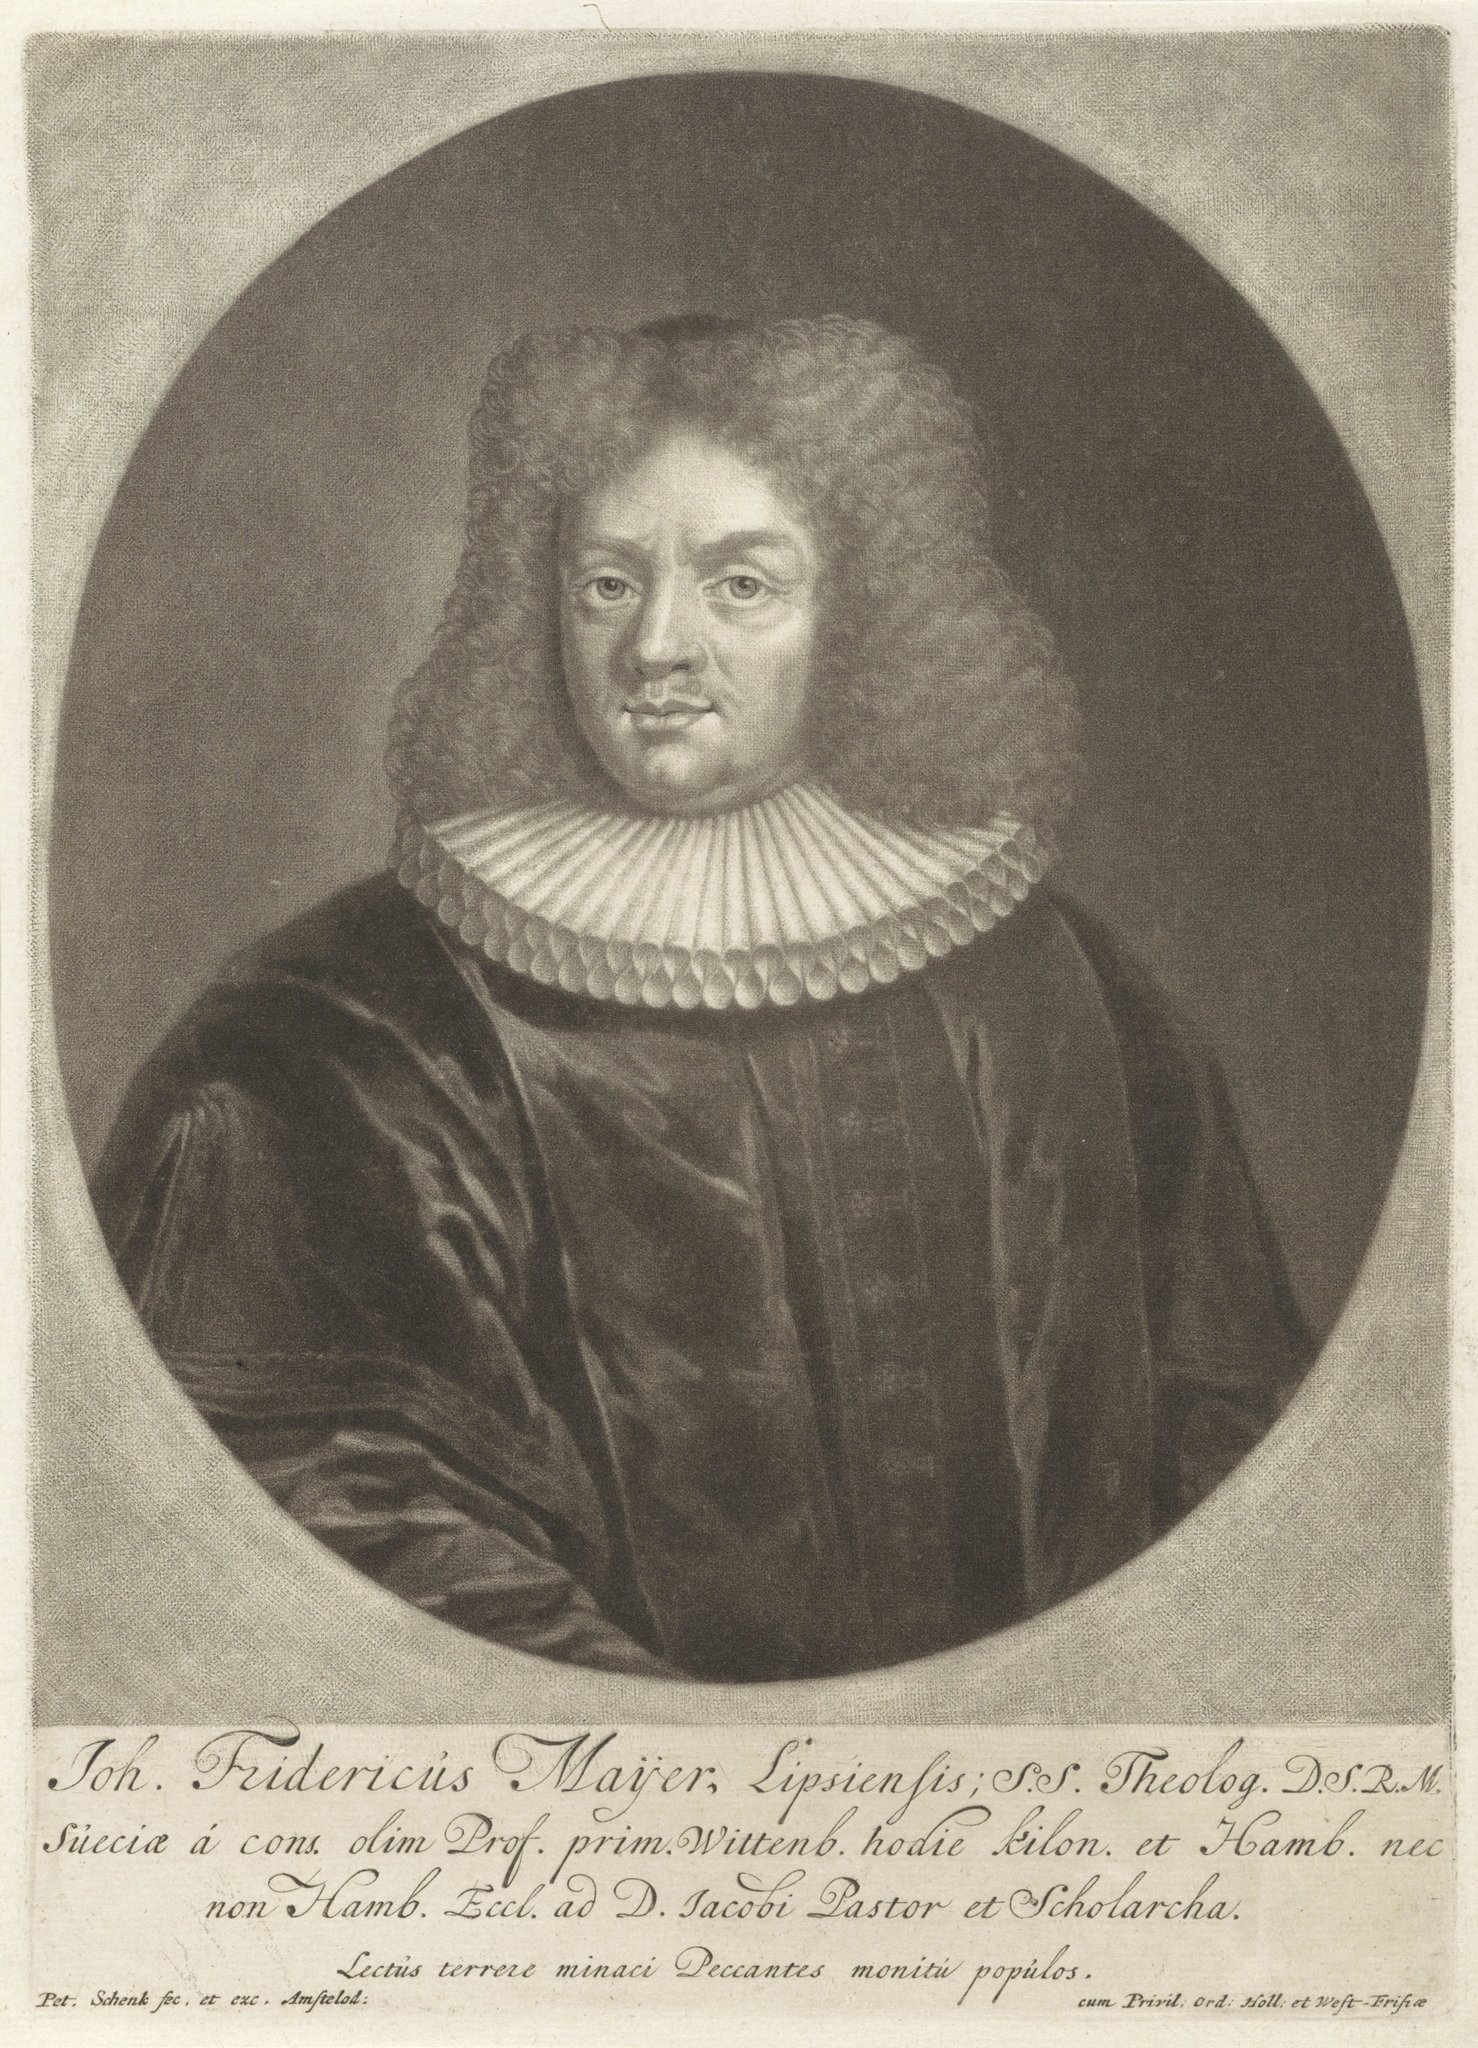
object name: print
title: Portret van Johann Friedrich Mayer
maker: pieter schenk (i)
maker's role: print maker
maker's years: 1660-1711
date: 1670-1713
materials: paper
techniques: mezzotint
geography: amsterdam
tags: theologian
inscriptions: collector's mark: Lugt 2228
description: De Duitse theoloog Johann Friedrich Mayer. In de marge zijn naam en titels.